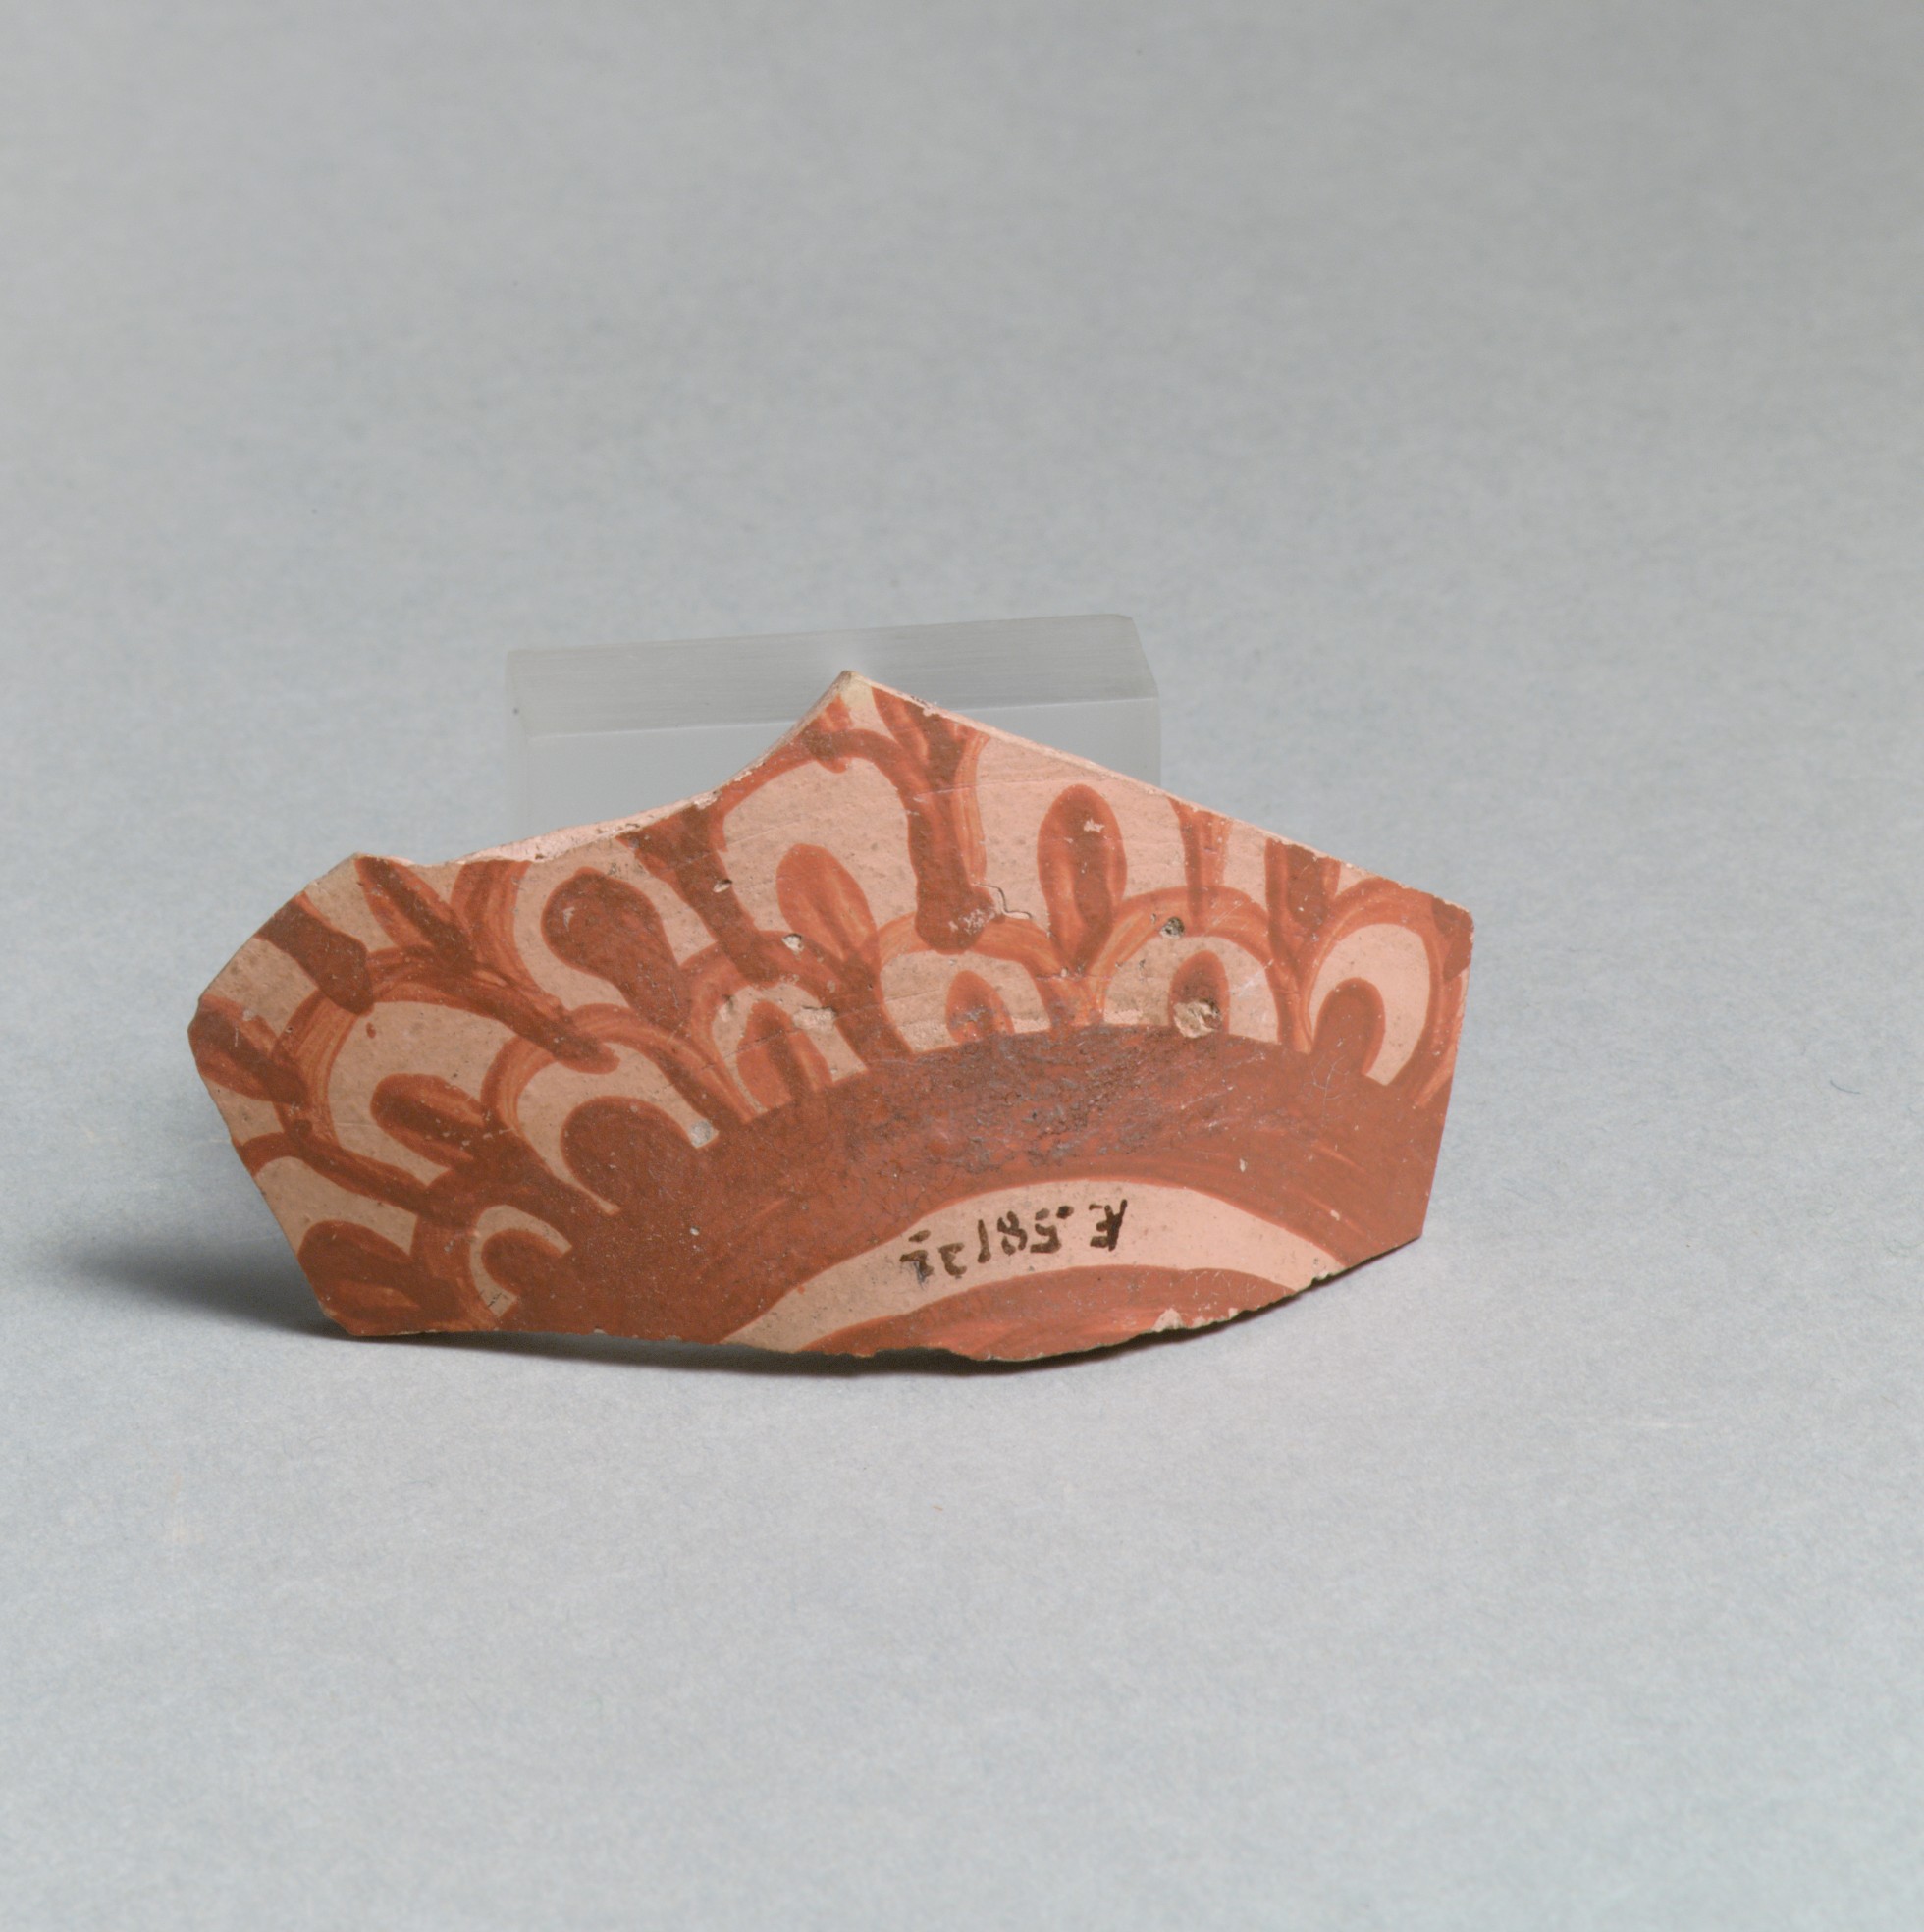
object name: vase fragment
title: Terracotta vessel fragment with scale pattern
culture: minoan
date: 1525-1450 BCE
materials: terracotta